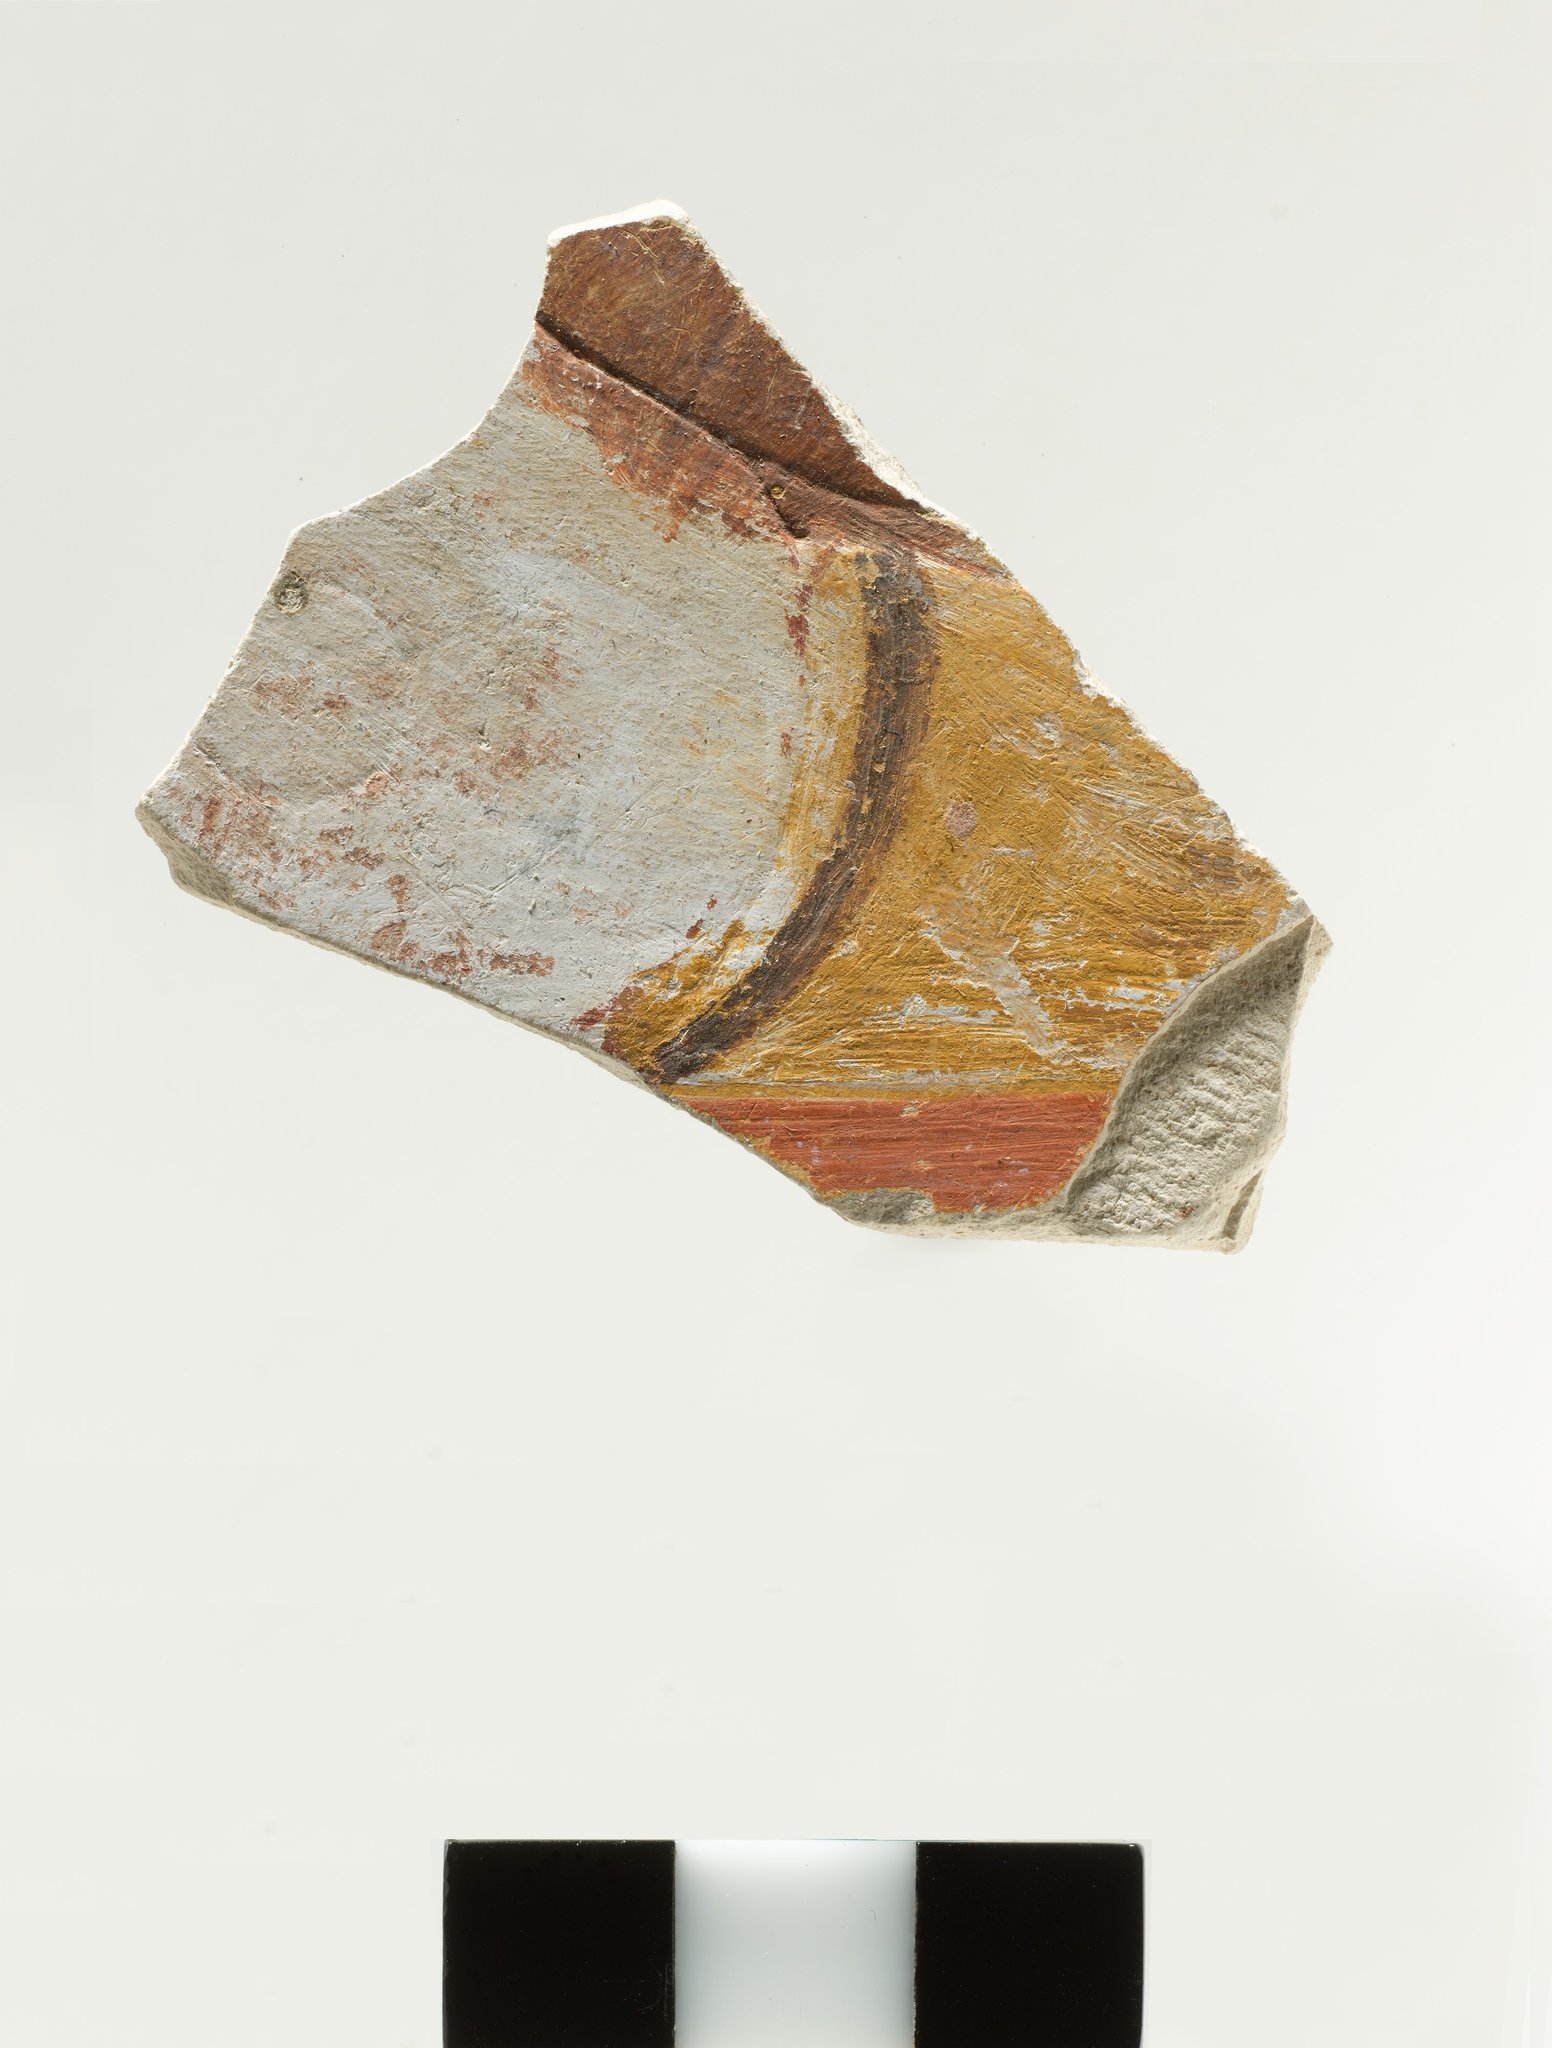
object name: relief fragment, tomb of meketre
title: Relief fragment from the tomb of Meketre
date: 1981-1975 BCE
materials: limestone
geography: egypt